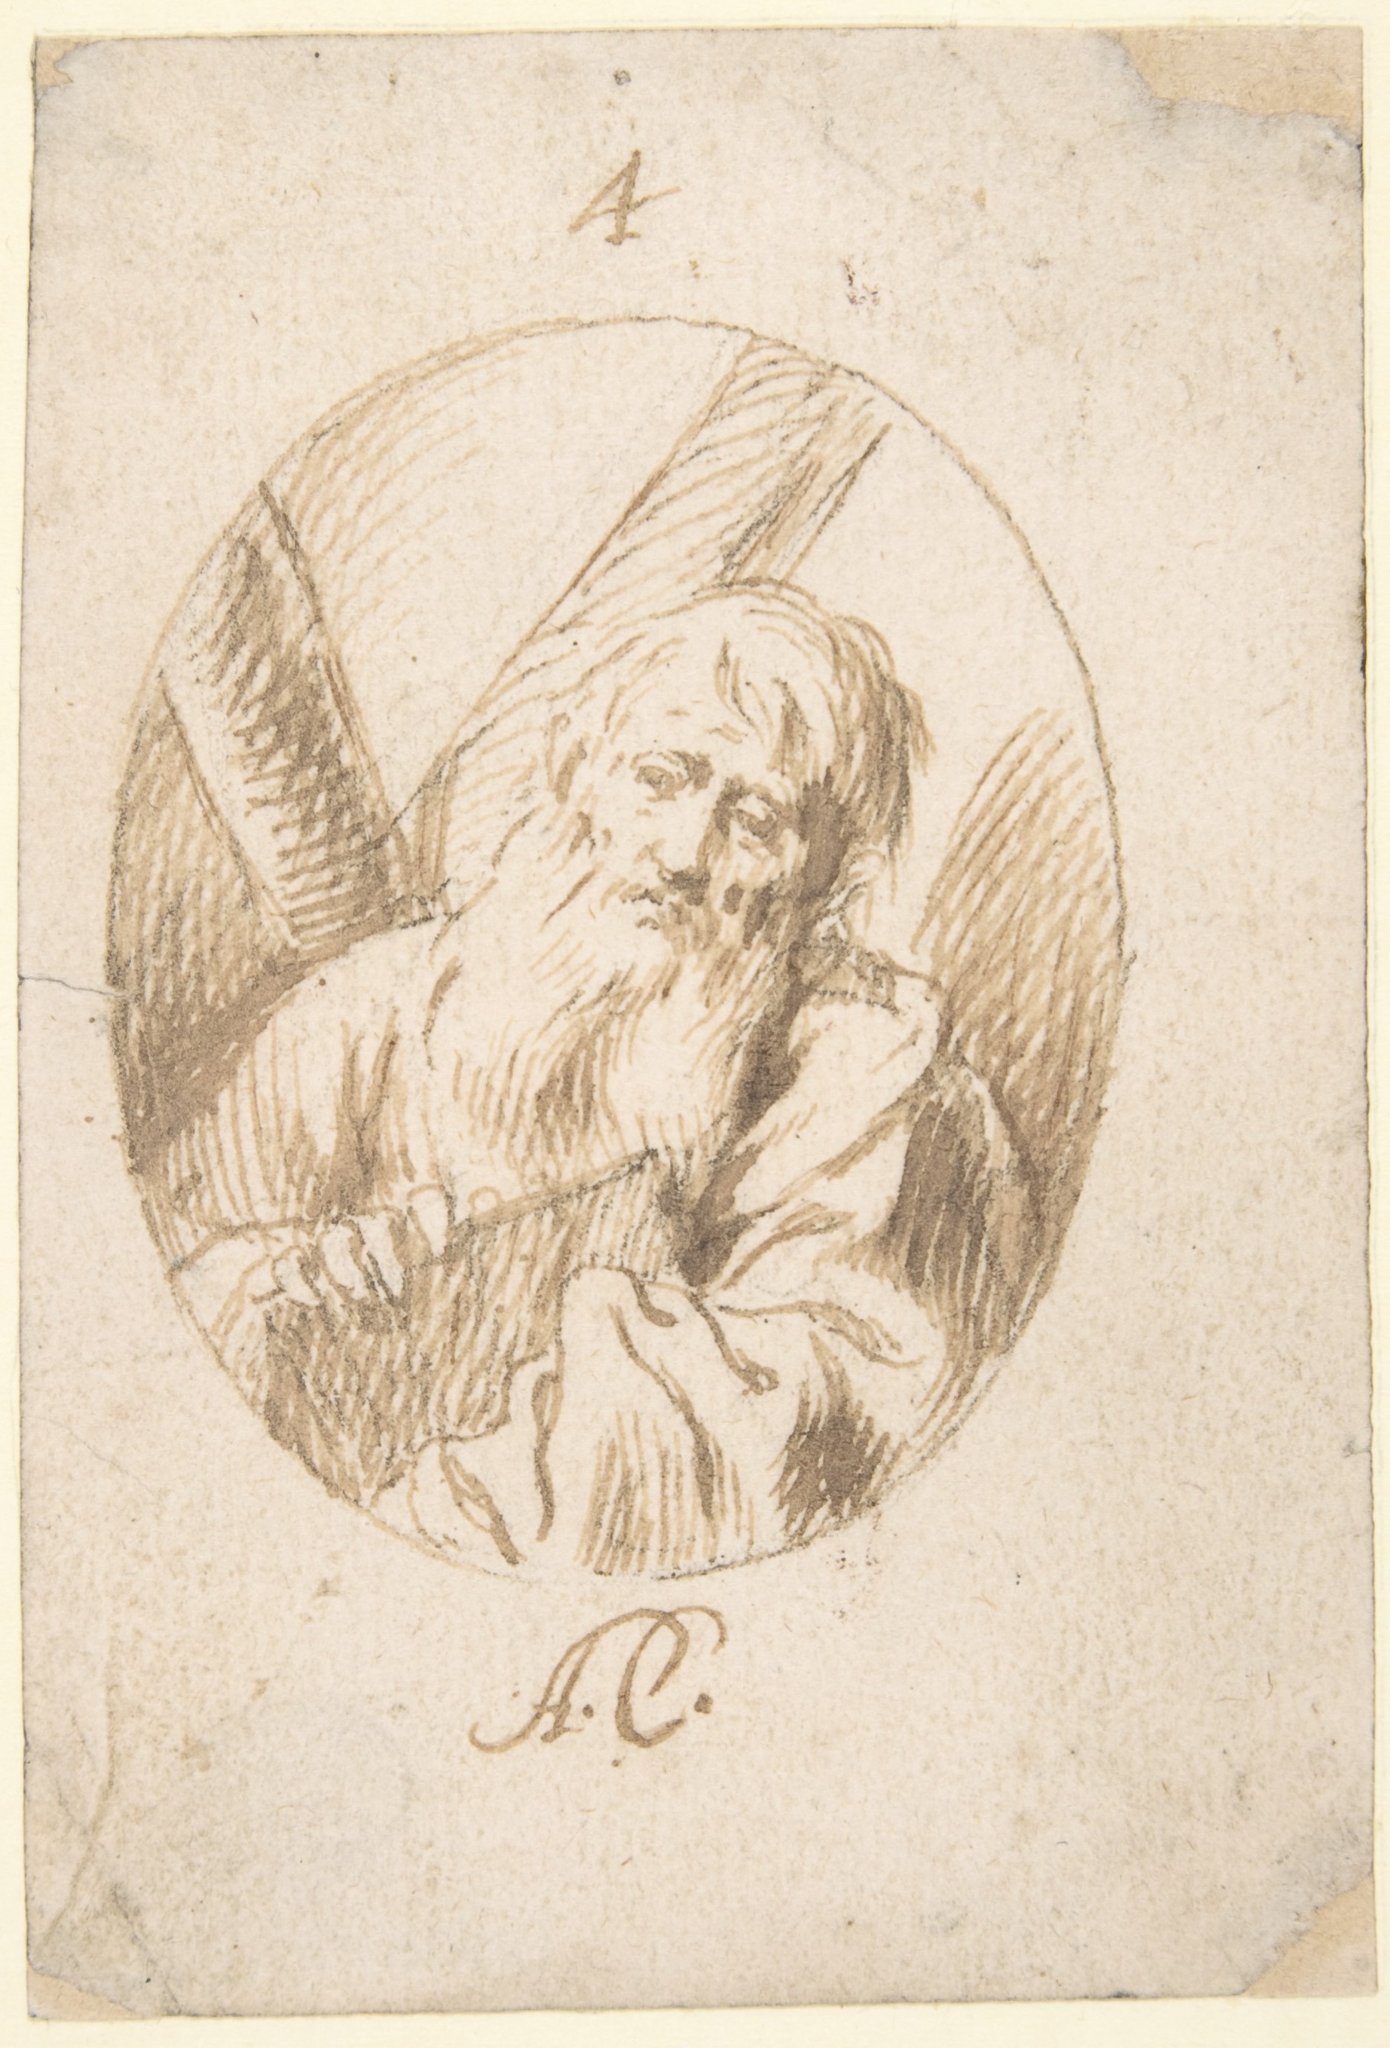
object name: drawing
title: Half-length Figure of St. Andrew in an Oval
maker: antonio del castillo y saavedra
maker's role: artist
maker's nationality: spanish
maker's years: 1616-1668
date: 1616-1668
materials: chalk, ink, paper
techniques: pen, drawing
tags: apostles,saints